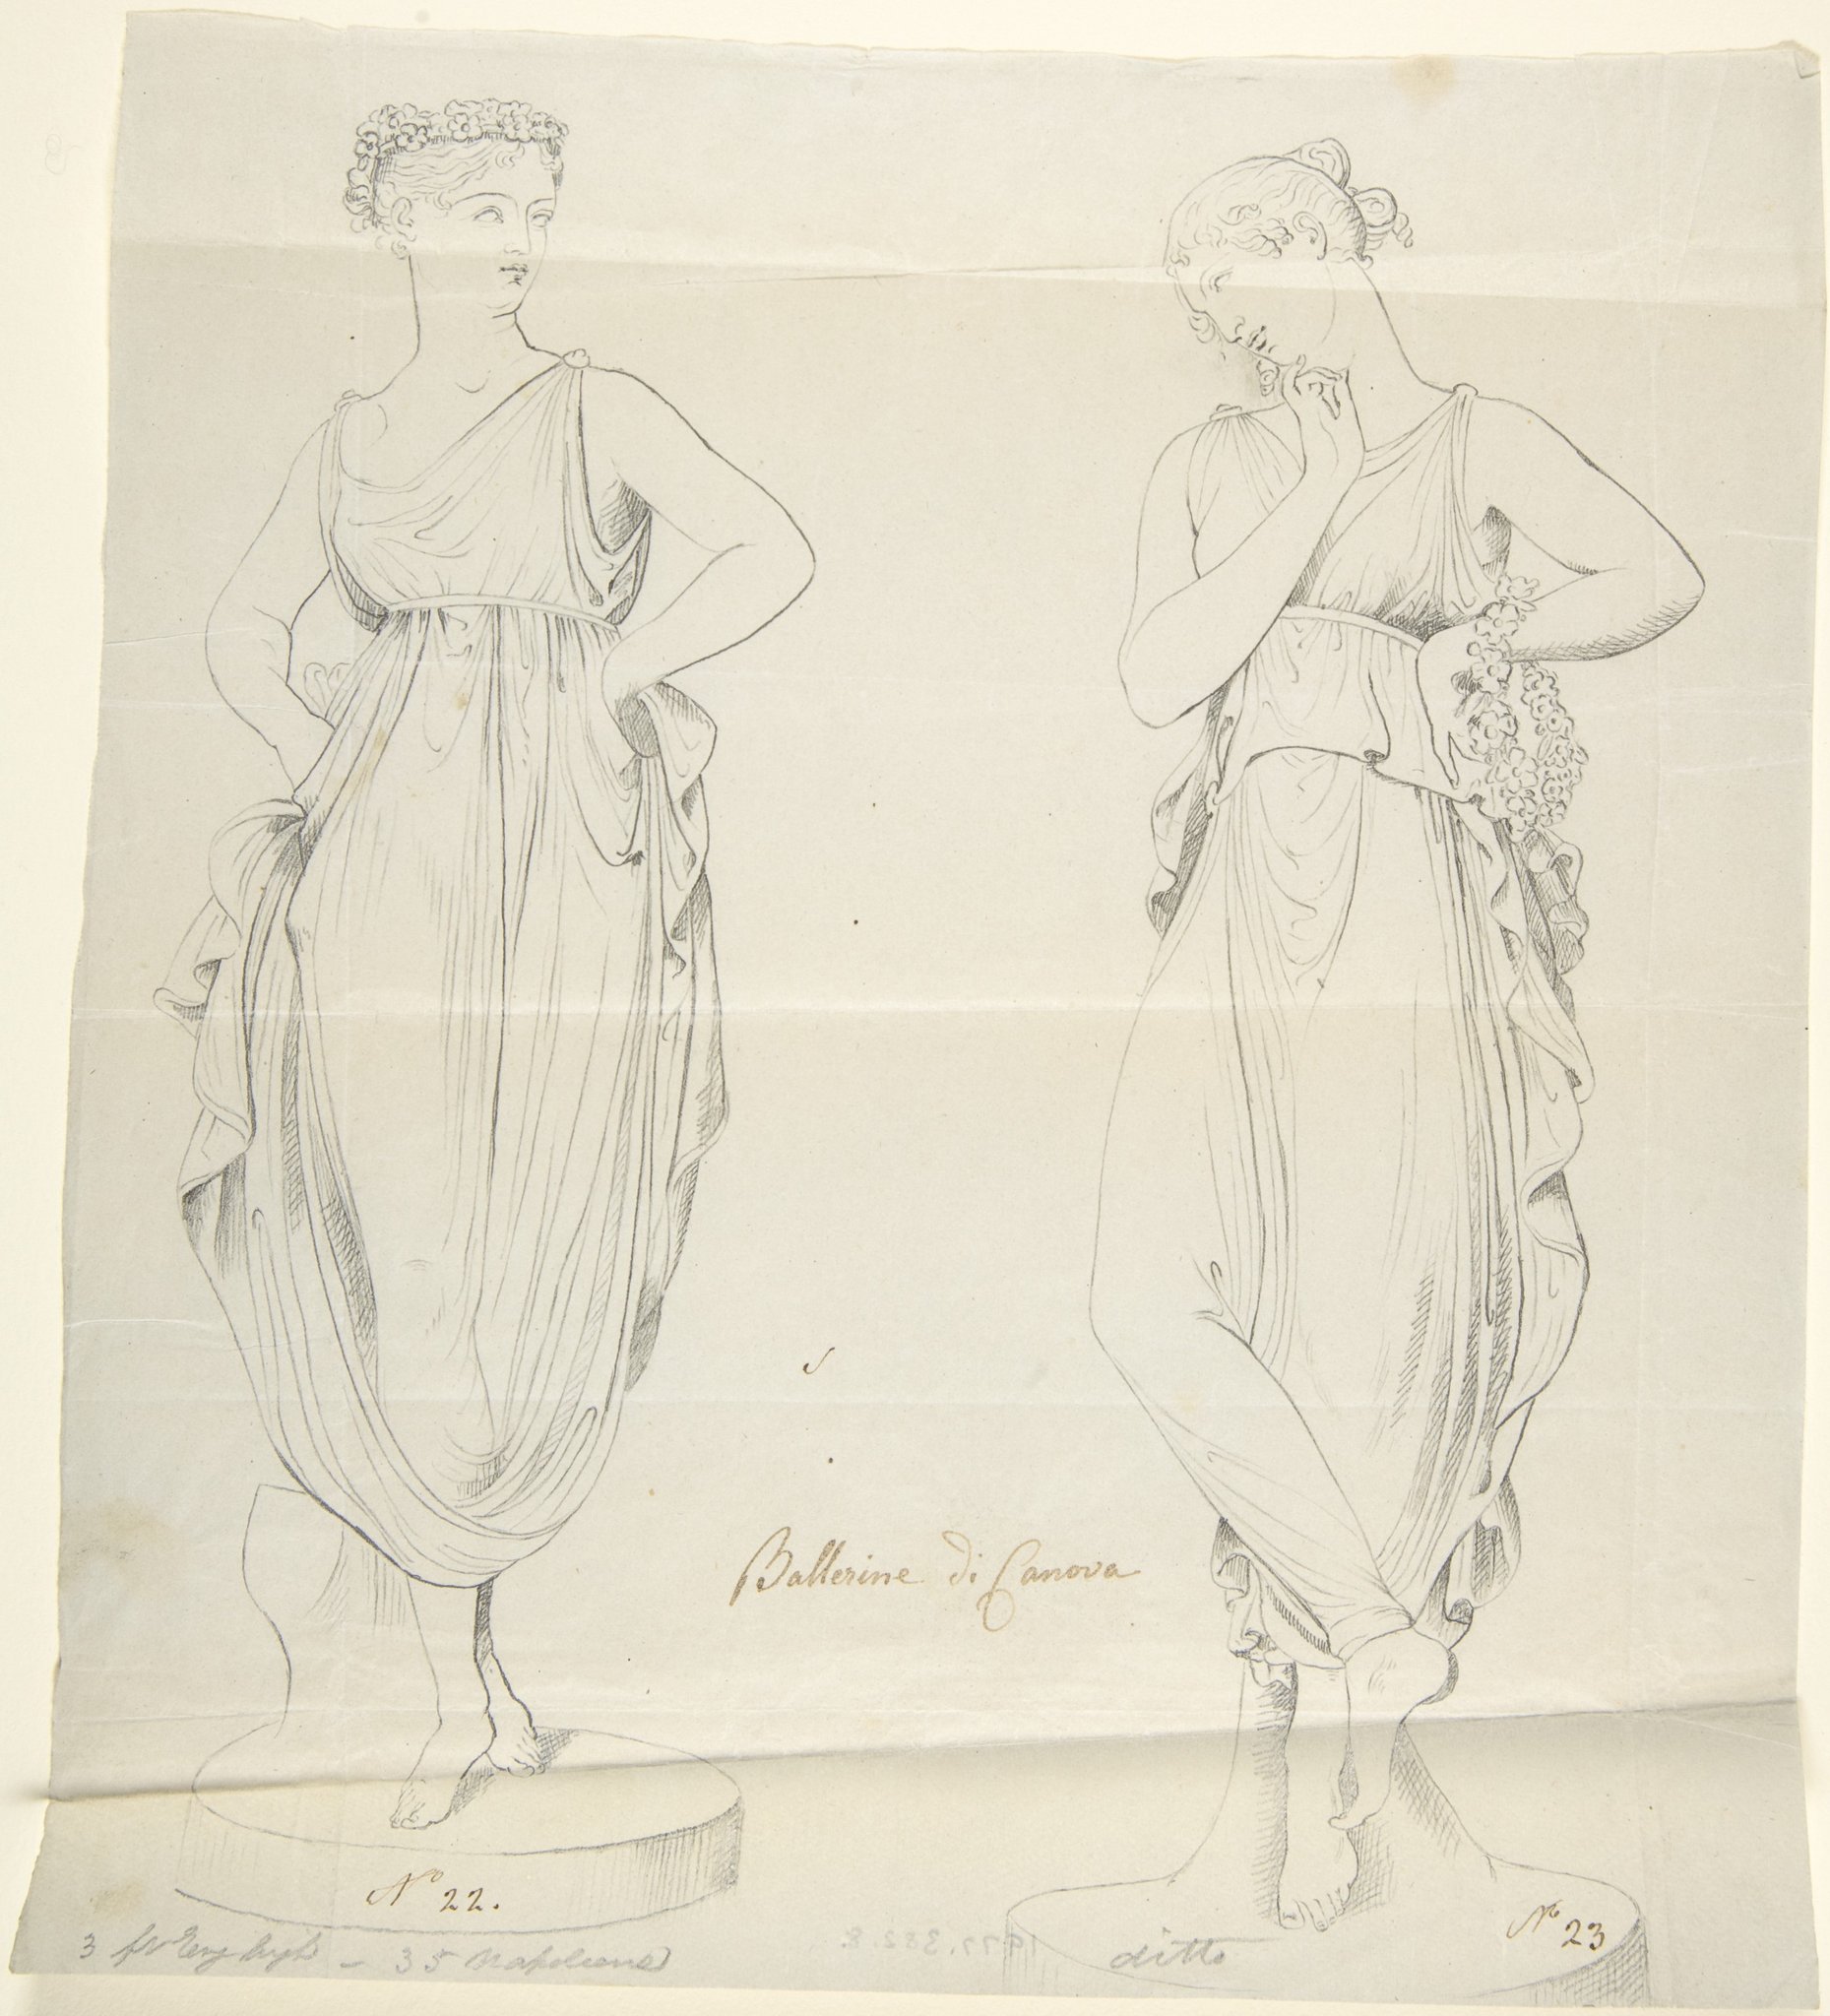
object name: drawing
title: Sketch of two statues: Ballerinas by Canova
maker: john gibson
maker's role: artist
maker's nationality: british, born wales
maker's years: 1790-1866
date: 1850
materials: graphite, ink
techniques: pen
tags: women